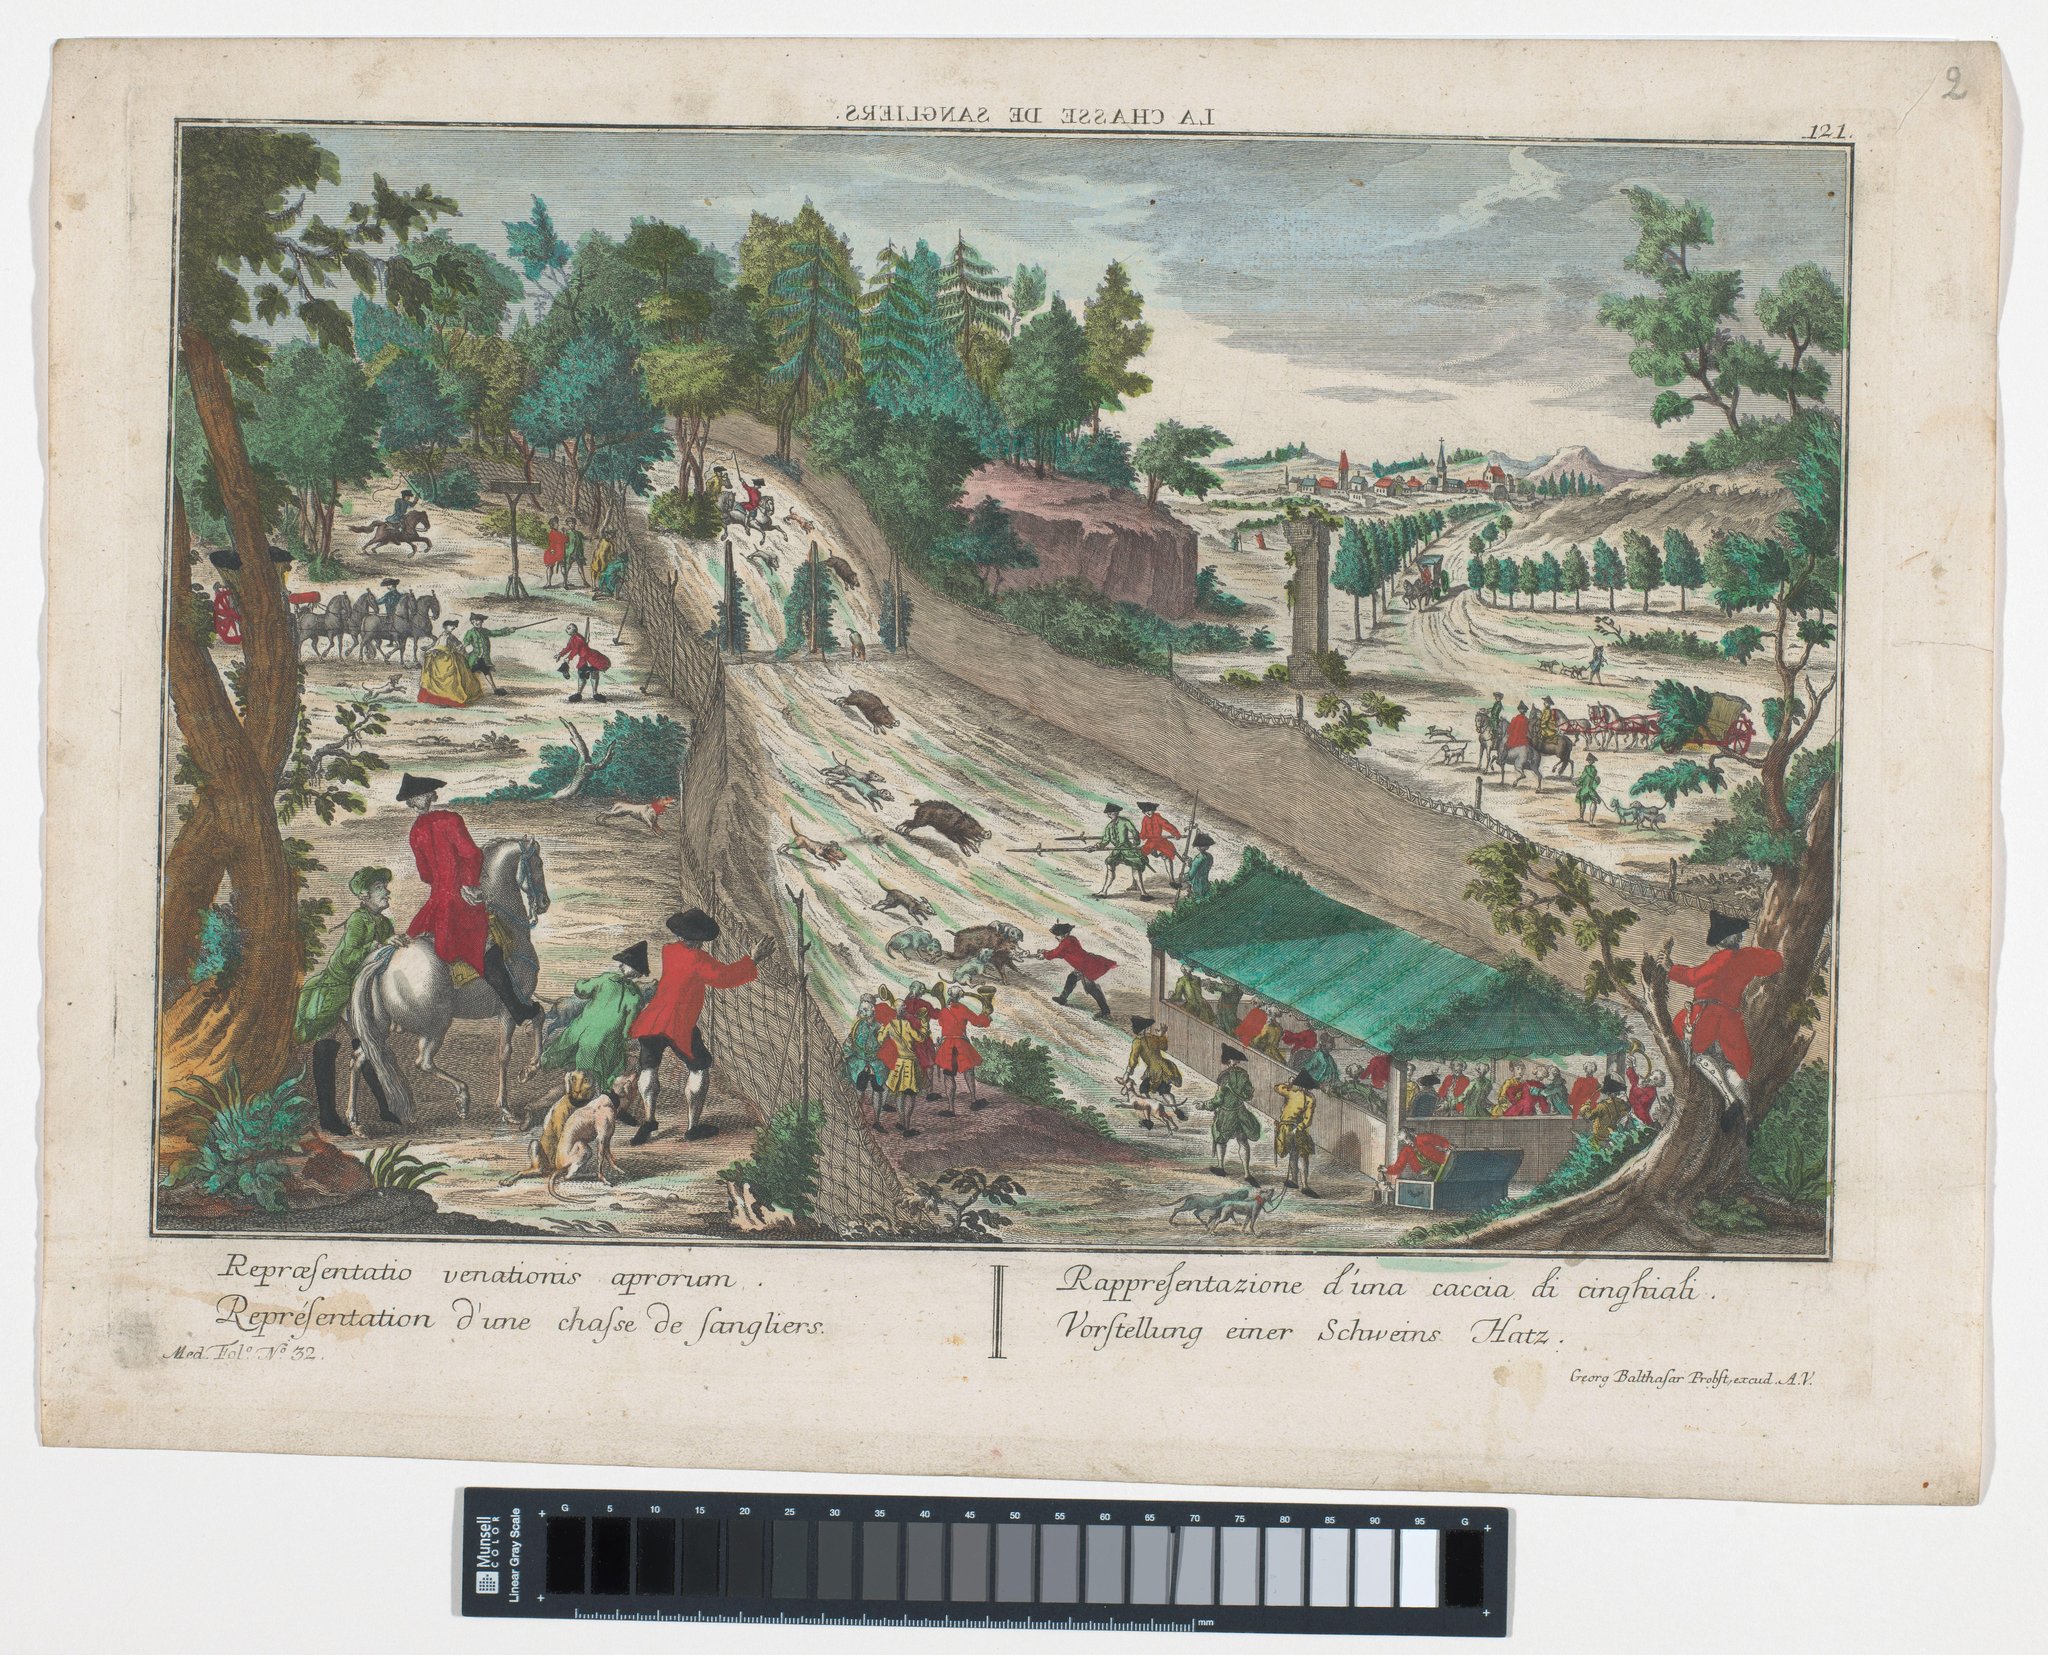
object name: opticaprent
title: Jachttaferelen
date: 1742-1801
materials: paper, watercolor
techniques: brush, etching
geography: germany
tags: hunting dogs, boar-hunting, hunters hunting (n.b.: in 1988-1990 this notation denoted the concept of 43c11421 'hunters resting during the hunt'), hoofed animals: boar, horse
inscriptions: watermark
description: De serie “Jachttaferelen”, met het nummer 32, bevat vier prenten met de nummers 119-122, waarvan dit nummer 121 is.